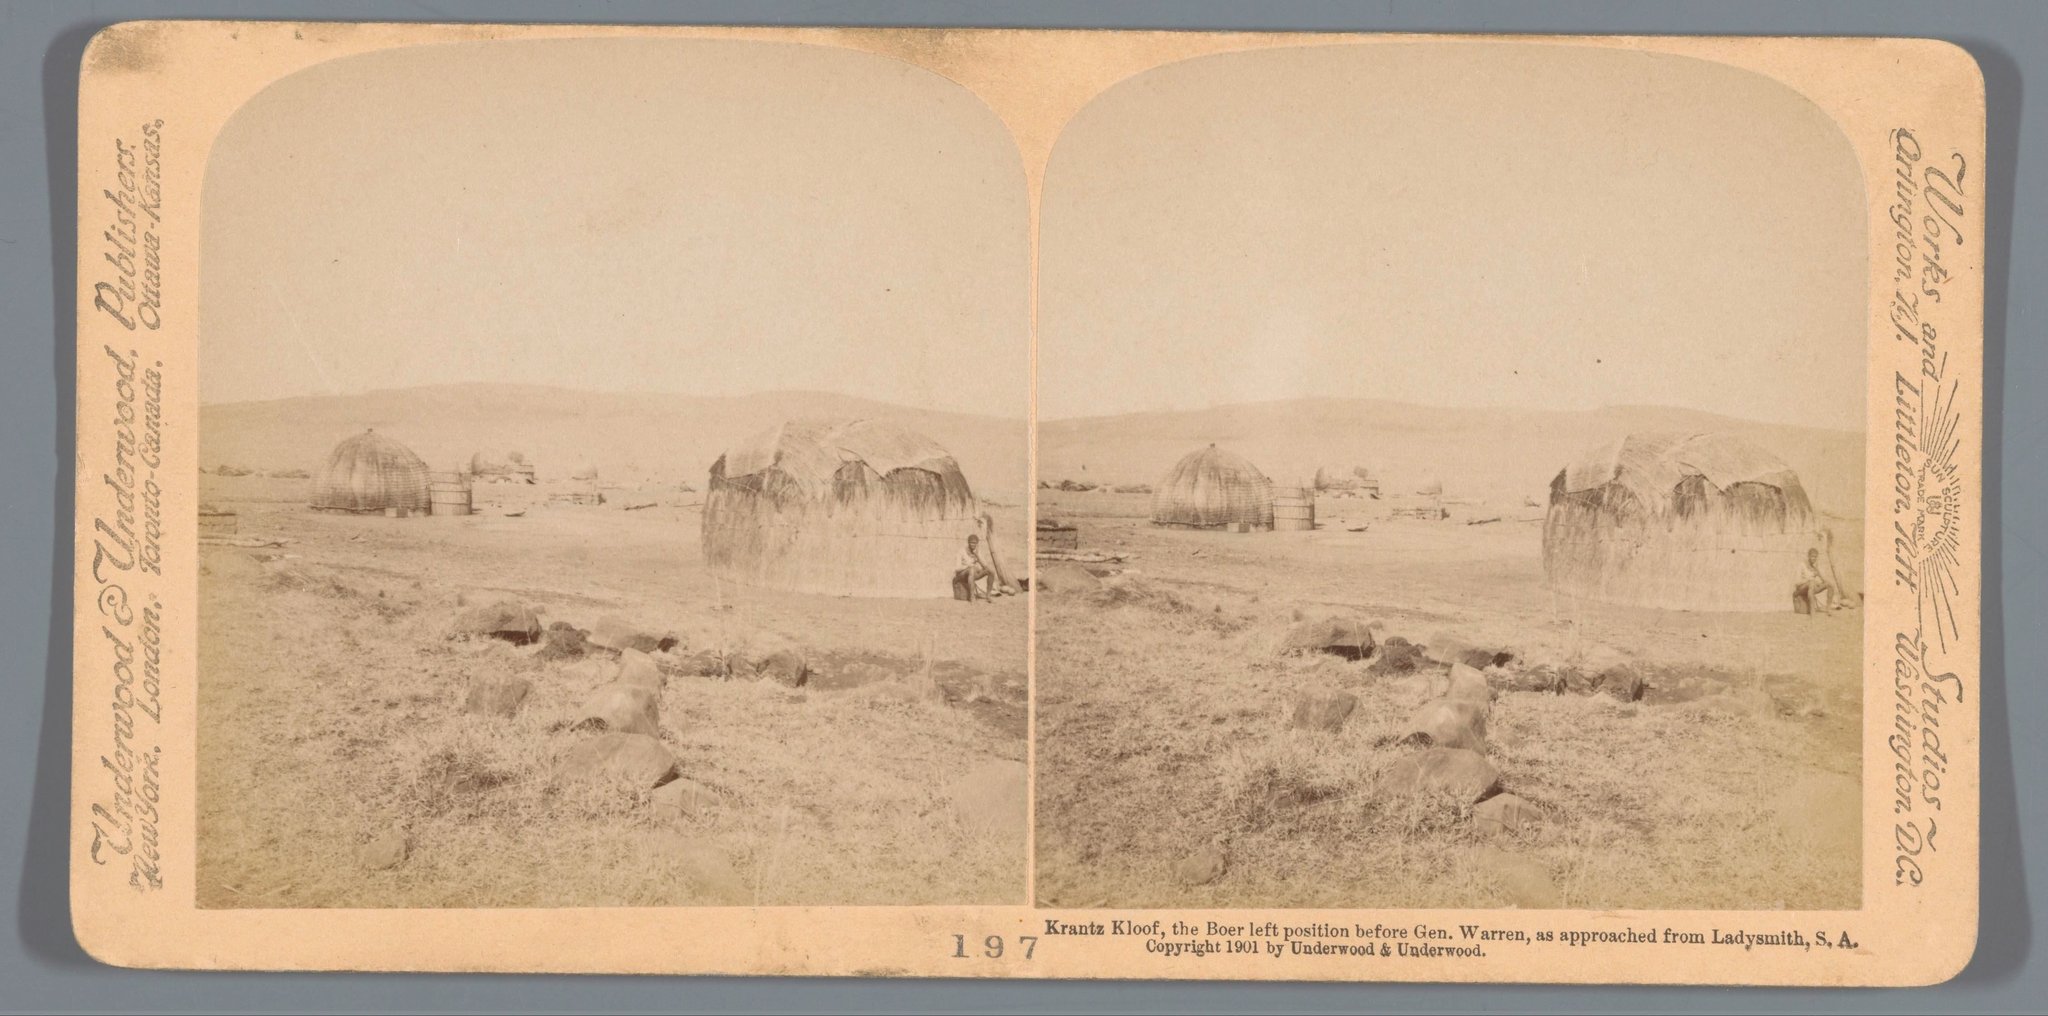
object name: stereograph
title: Gezicht op hutten in de Krantzkloof in Zuid-Afrika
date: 1901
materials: cardboard, photographic support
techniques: albumen print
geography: south africa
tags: hut, cabin, lodge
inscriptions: name: ‘Works and Studios Sun Sculpture trade mark Arlington N.J. Littleton N.H. Washington D.C.’, number: ‘197’